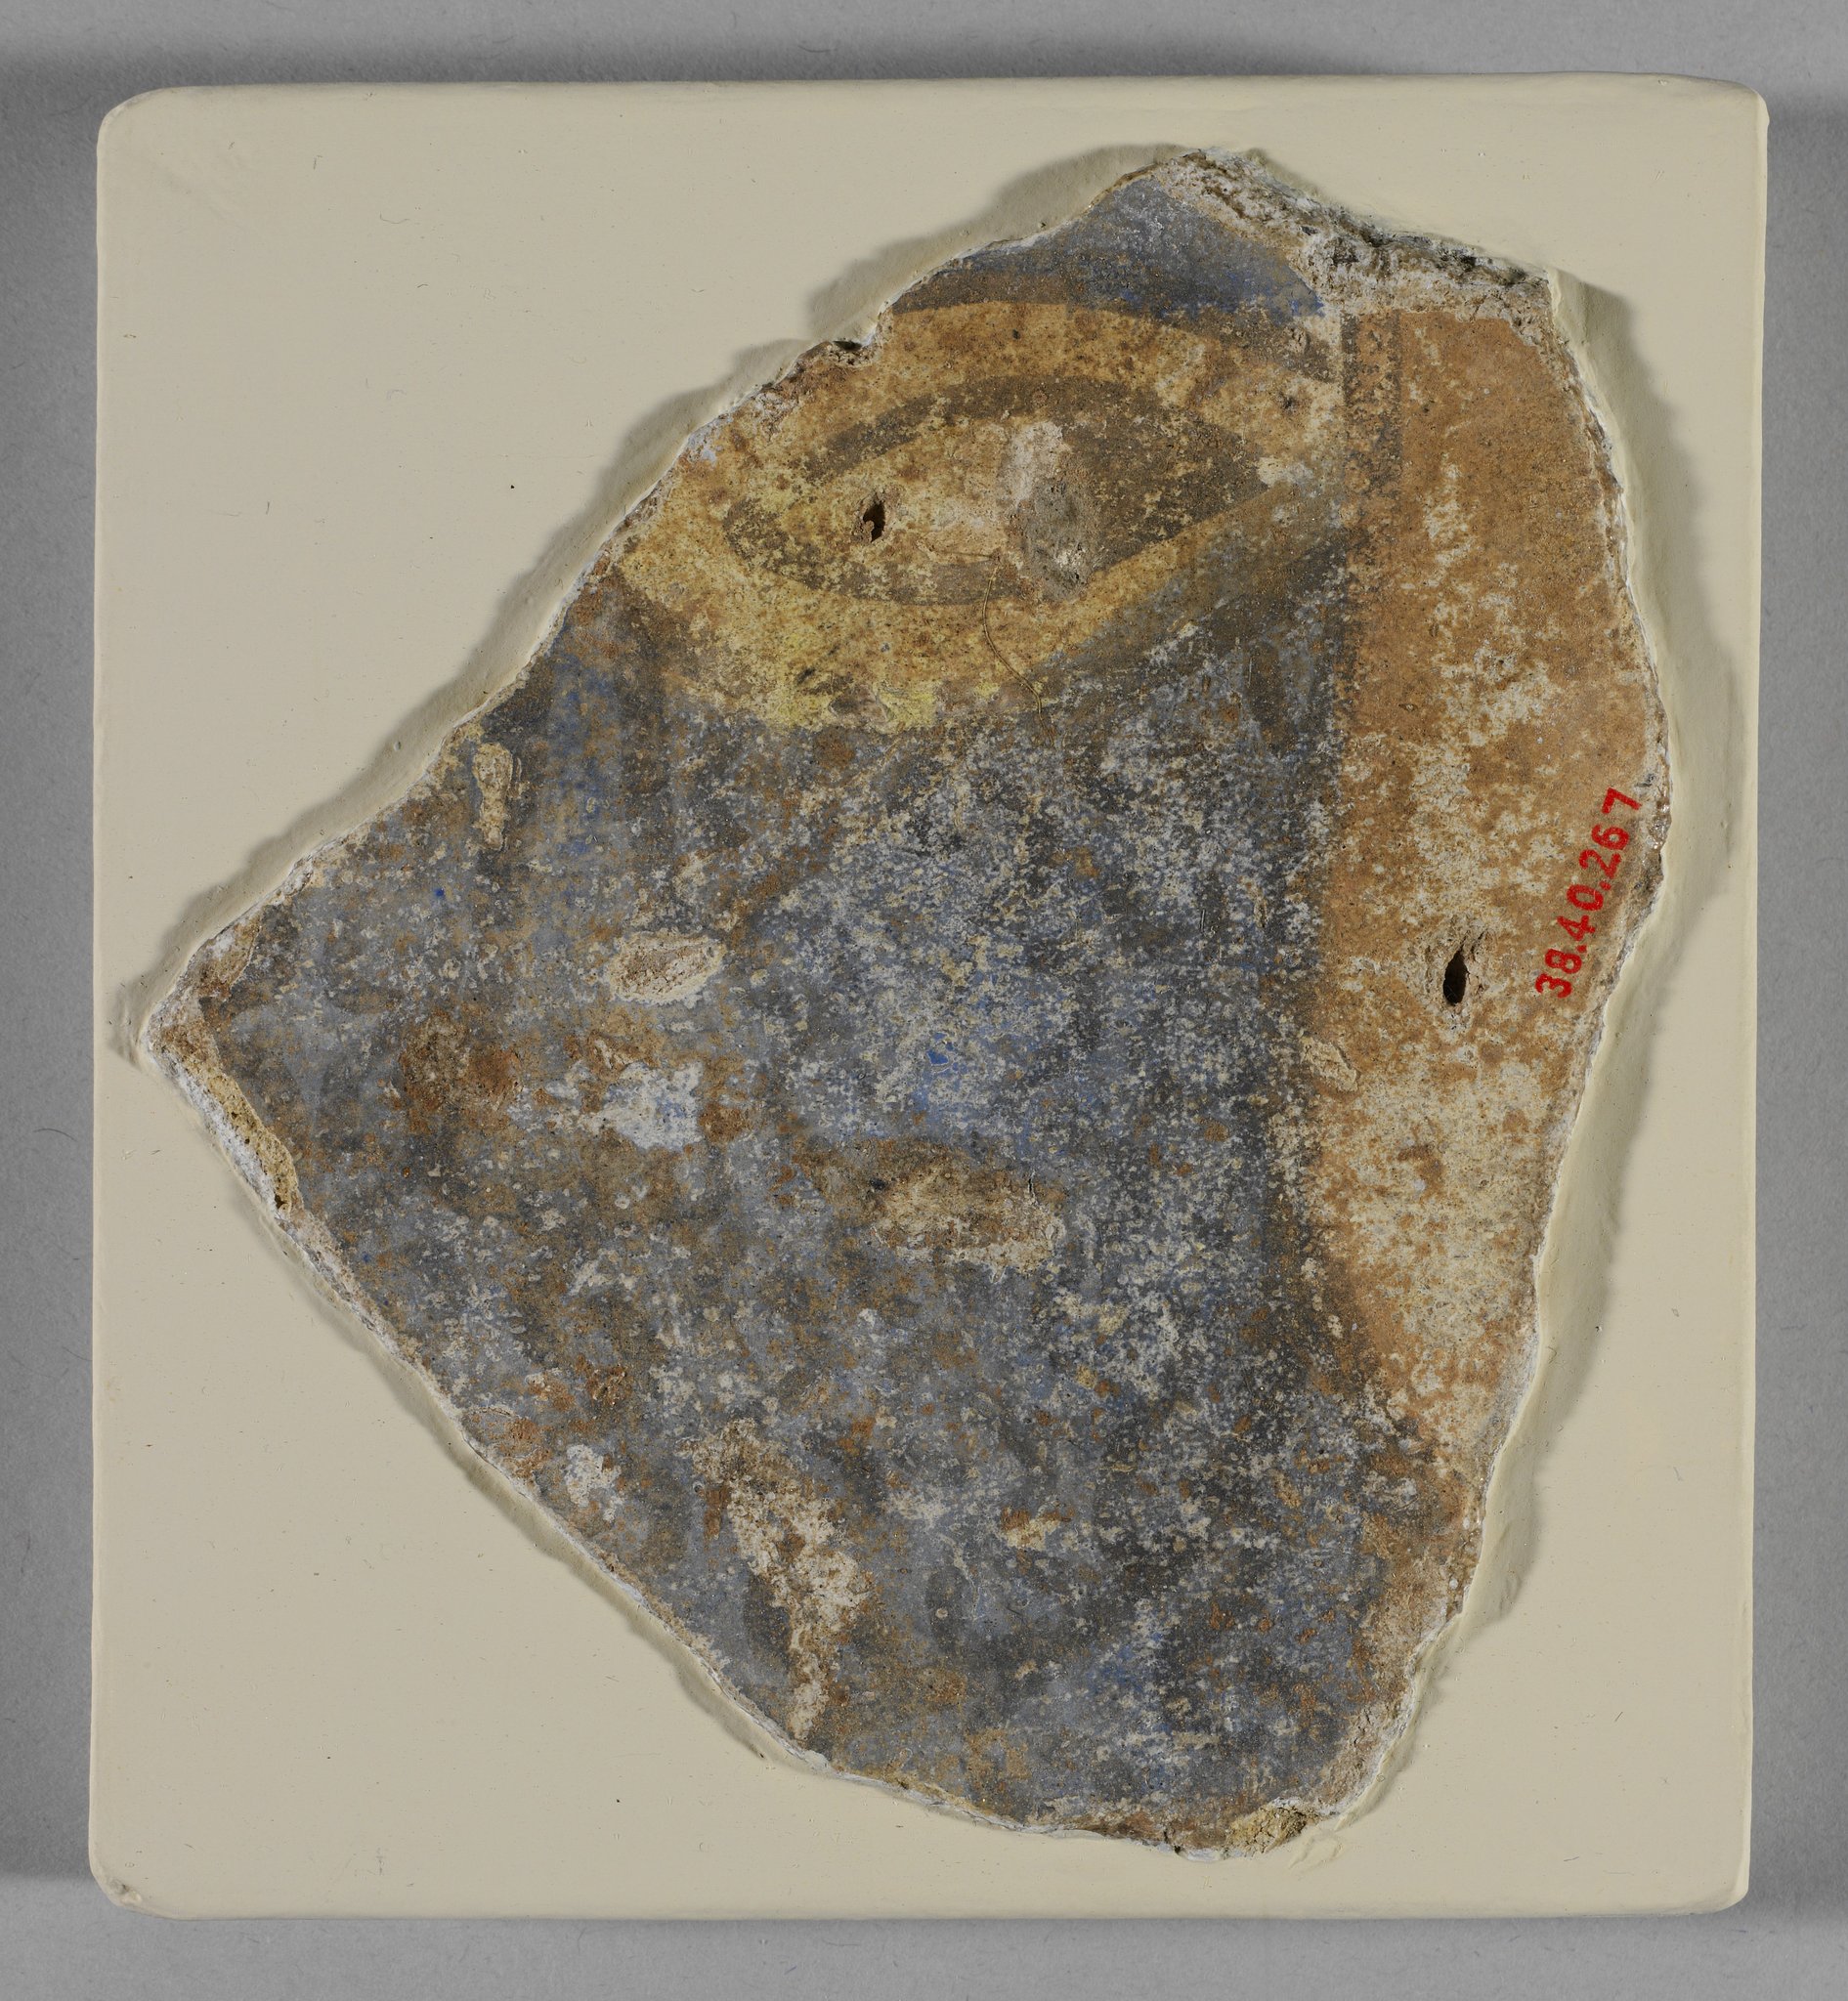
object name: wall painting fragment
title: Blue Figure, Possibly a Demon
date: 801-1000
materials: plaster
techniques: painting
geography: iran